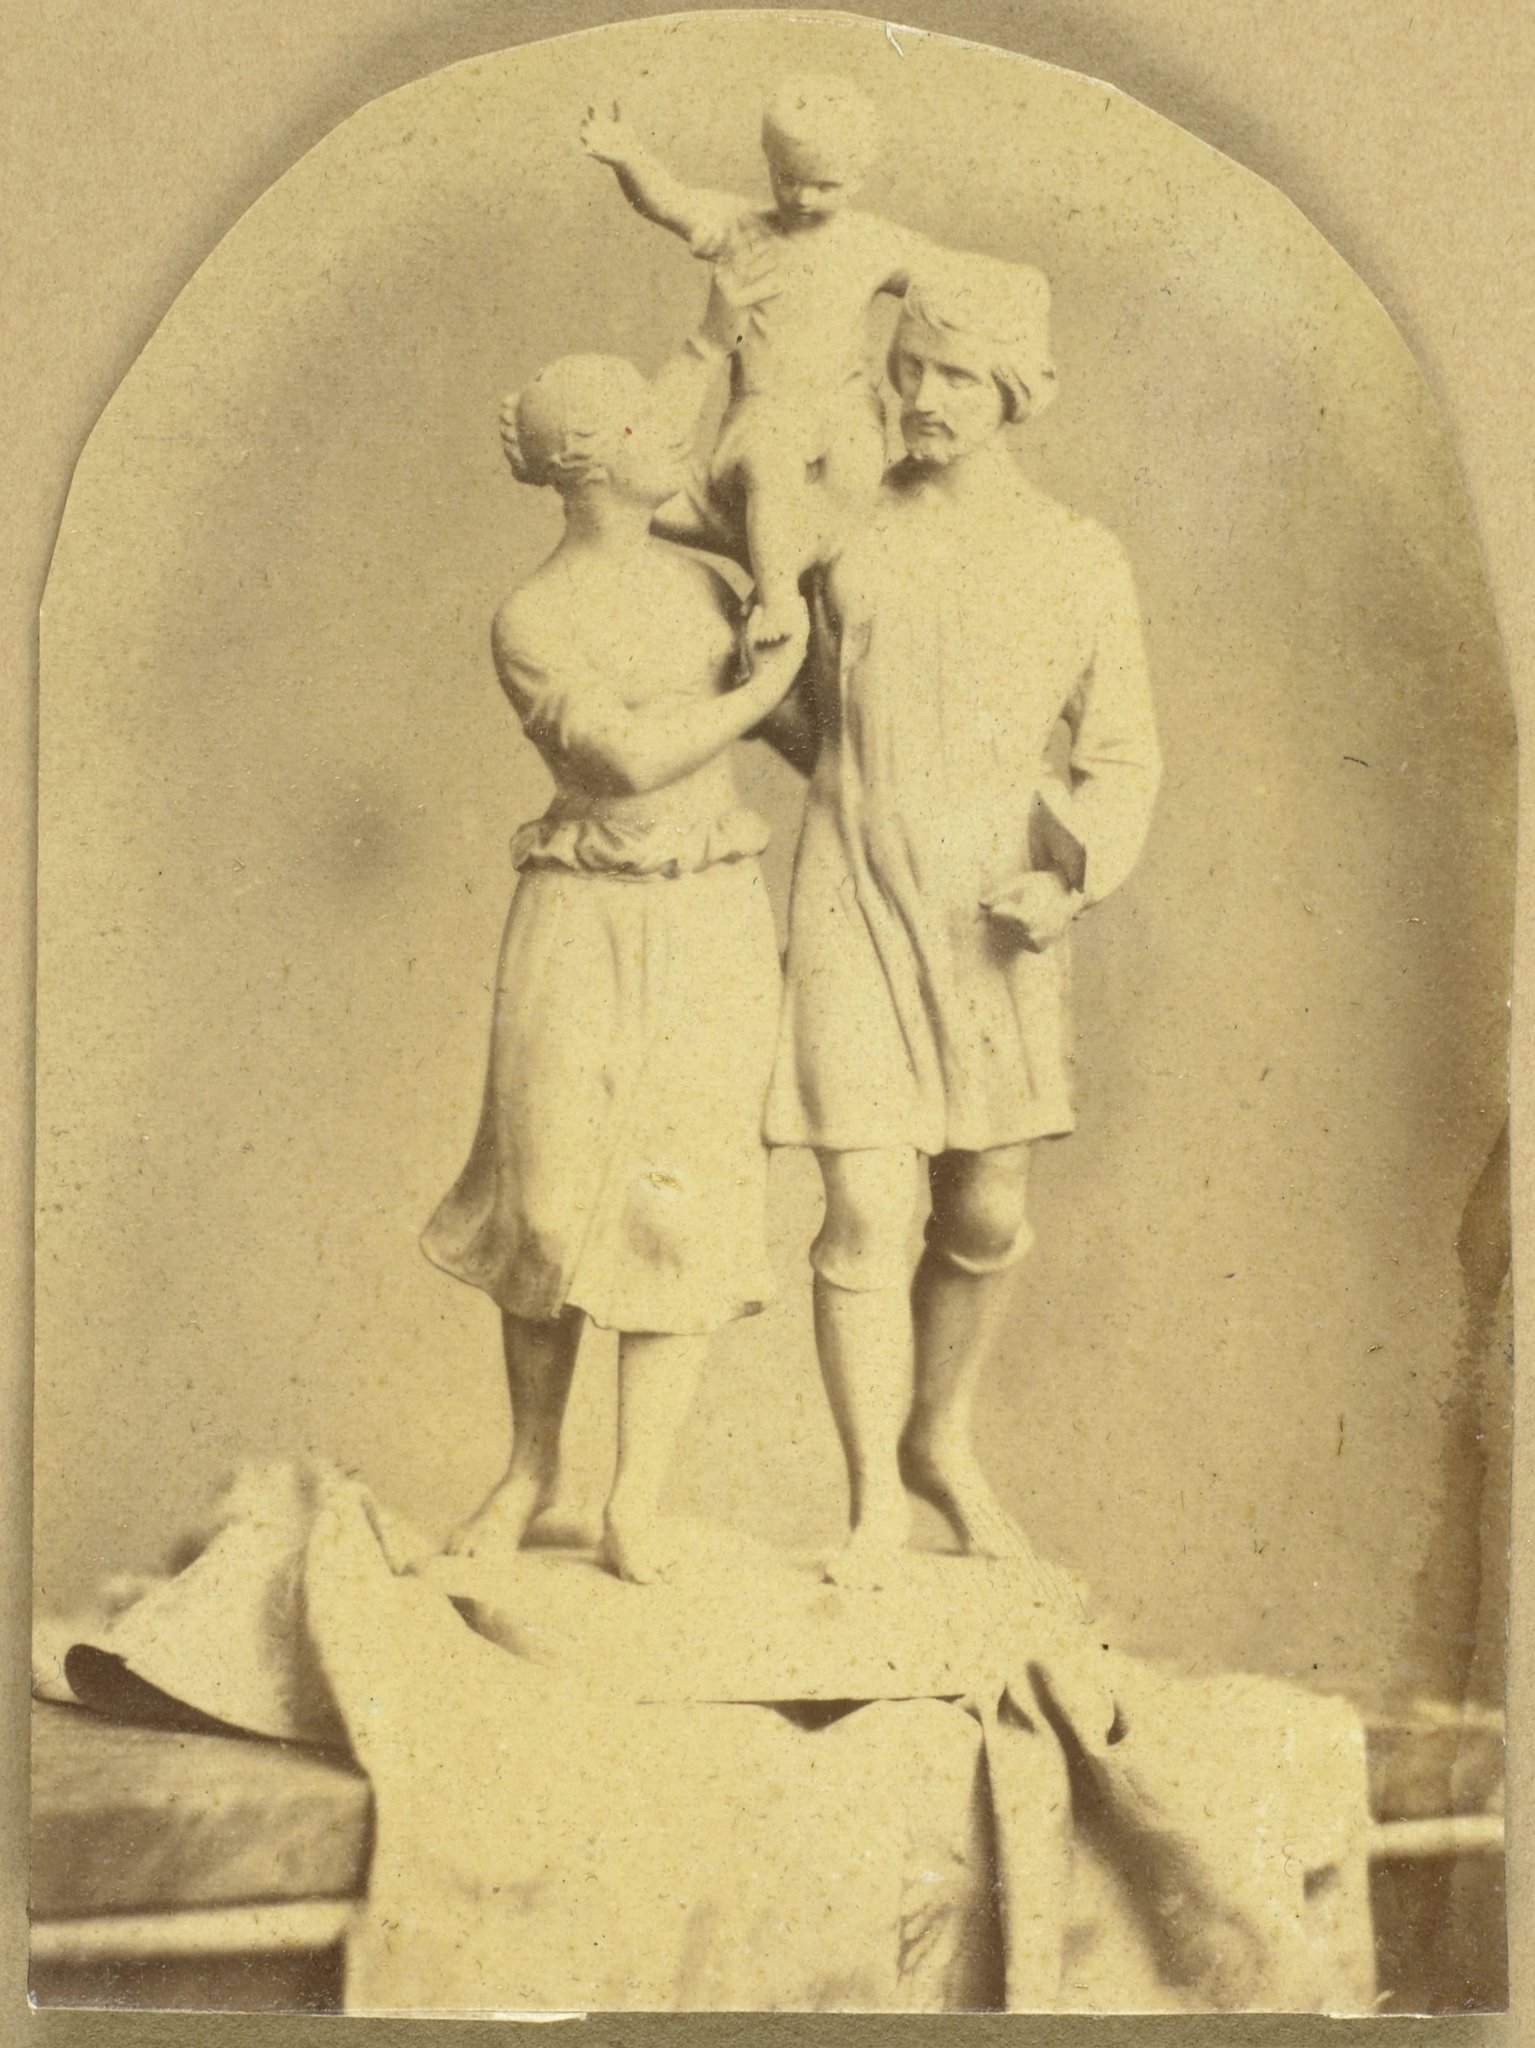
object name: photograph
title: Statuette van echtpaar met kind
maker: eduard isaac asser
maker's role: amateurfotograaf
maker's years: 1809-1894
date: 1852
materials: cardboard, paper, photographic support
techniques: salted paper print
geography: amsterdam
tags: sculpture